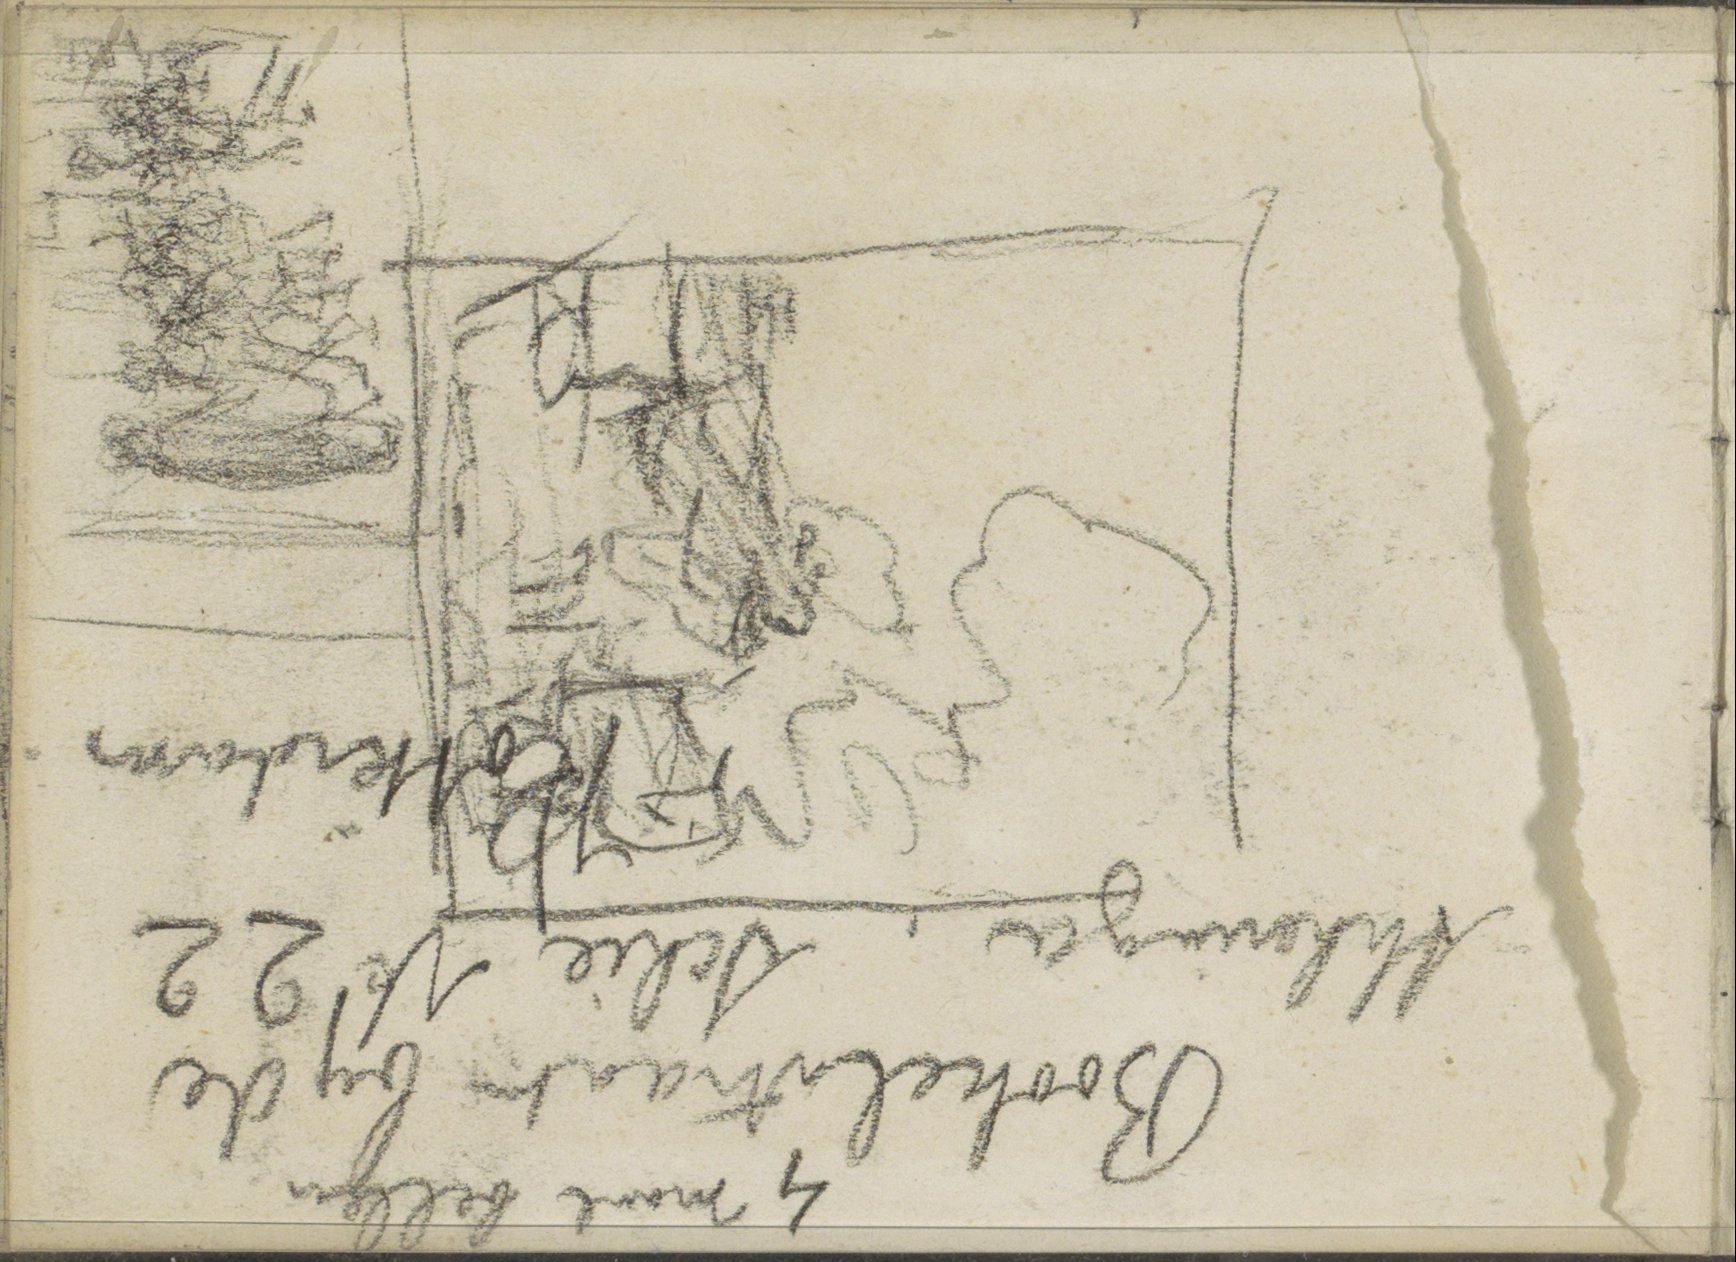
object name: sketchbook leaf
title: Studieblad met figuren en een landschap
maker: marius bauer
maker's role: draughtsman, print maker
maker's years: 1867-1932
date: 1877-1932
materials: chalk, paper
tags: landscapes, anatomy (non-medical)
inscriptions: annotation: ‘4 maart bellen/ Bookelstraat bij de/ Akkeringa, Schie No 22/ Rotterdam’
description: Pagina 66 uit een schetsboek met 32 bladen.